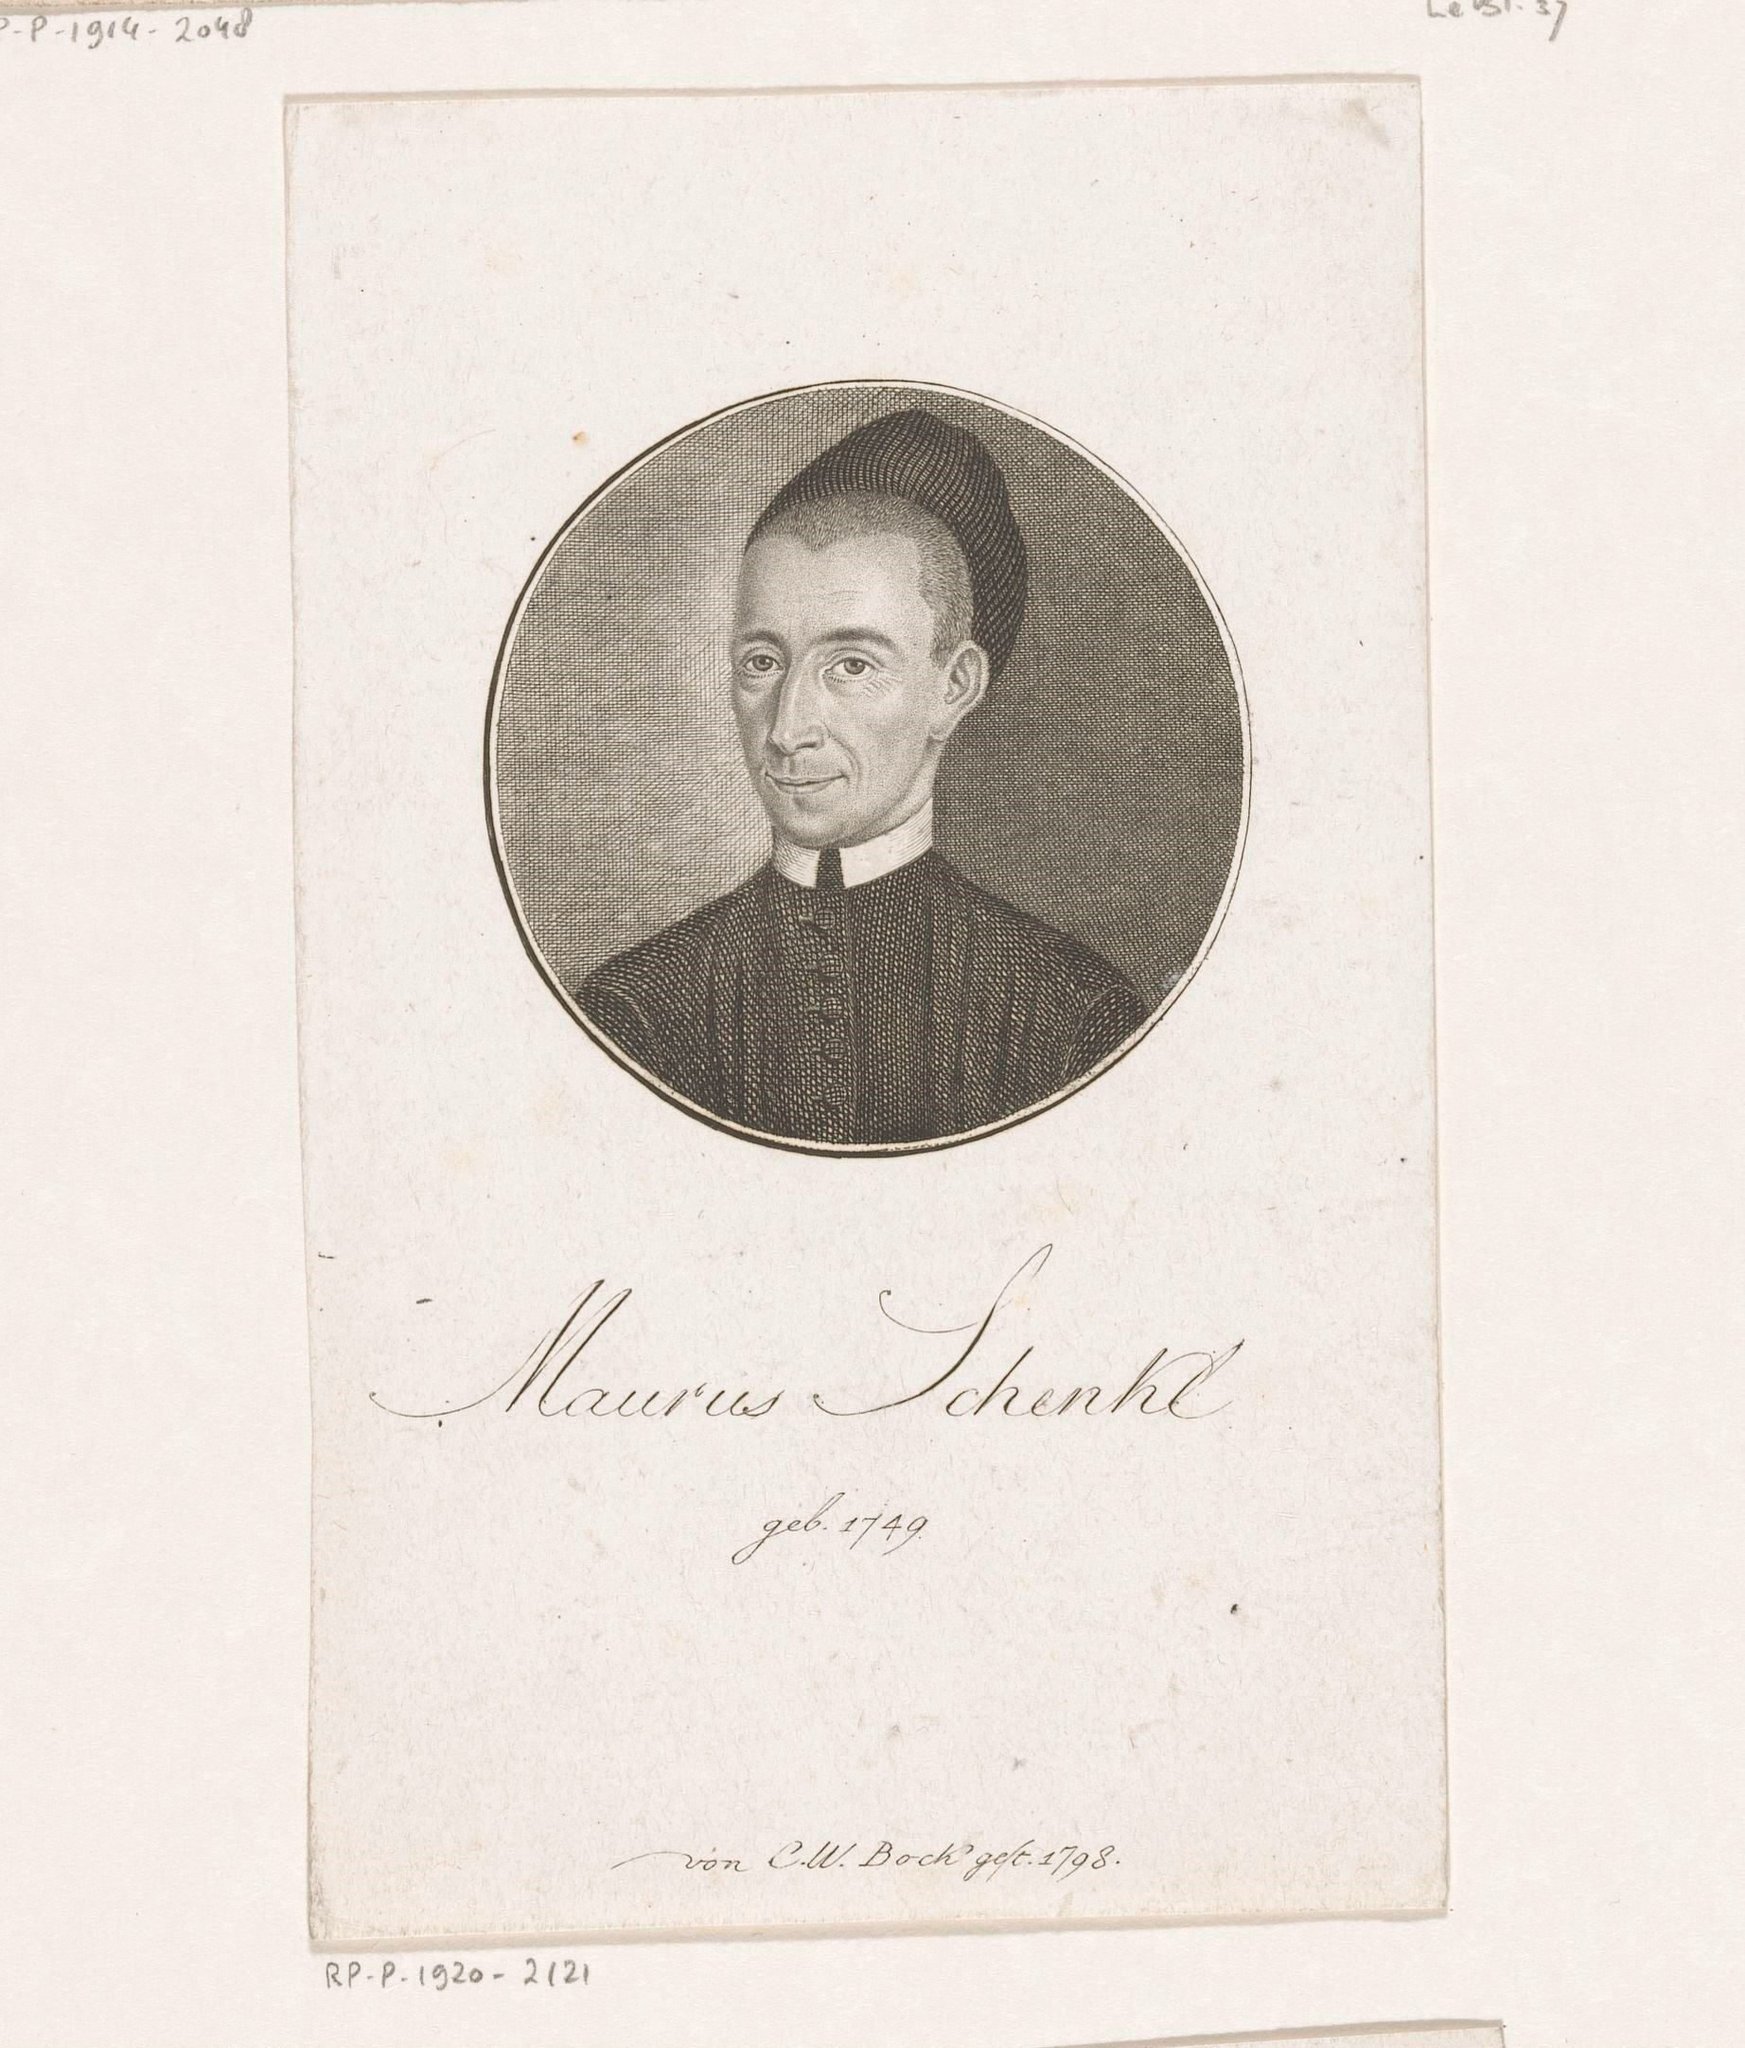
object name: print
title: Portret van Maurus Schenkl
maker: christoph wilhelm bock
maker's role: print maker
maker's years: 1755-1836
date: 1798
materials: paper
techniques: engraving, etching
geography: nuremberg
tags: amberg, historical persons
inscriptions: collector's mark: Lugt 2228